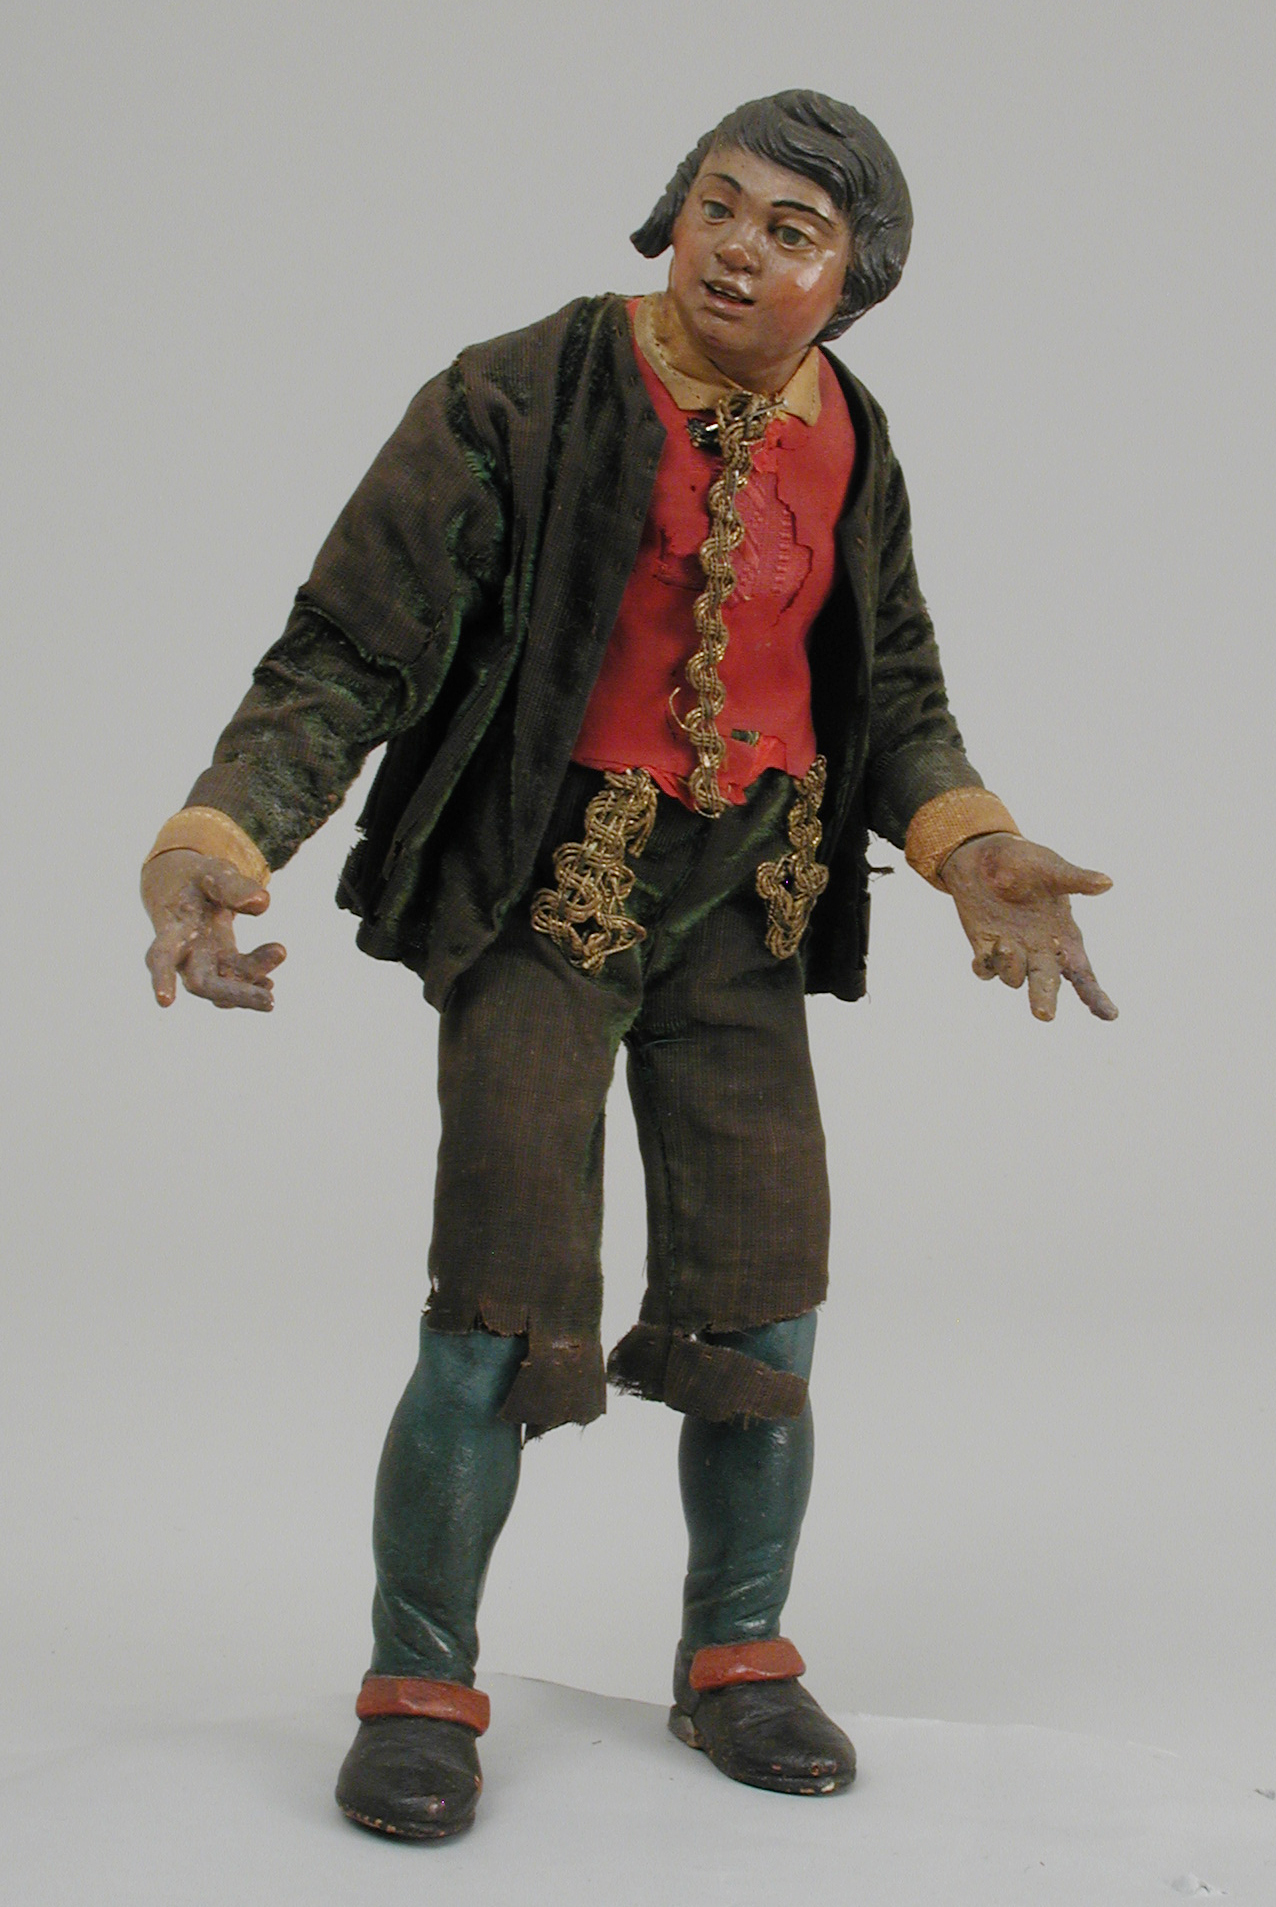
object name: crèche figure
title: Standing man in velvet suit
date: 1767-1833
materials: terracotta, fiber, velvet, metal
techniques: polychrome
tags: men